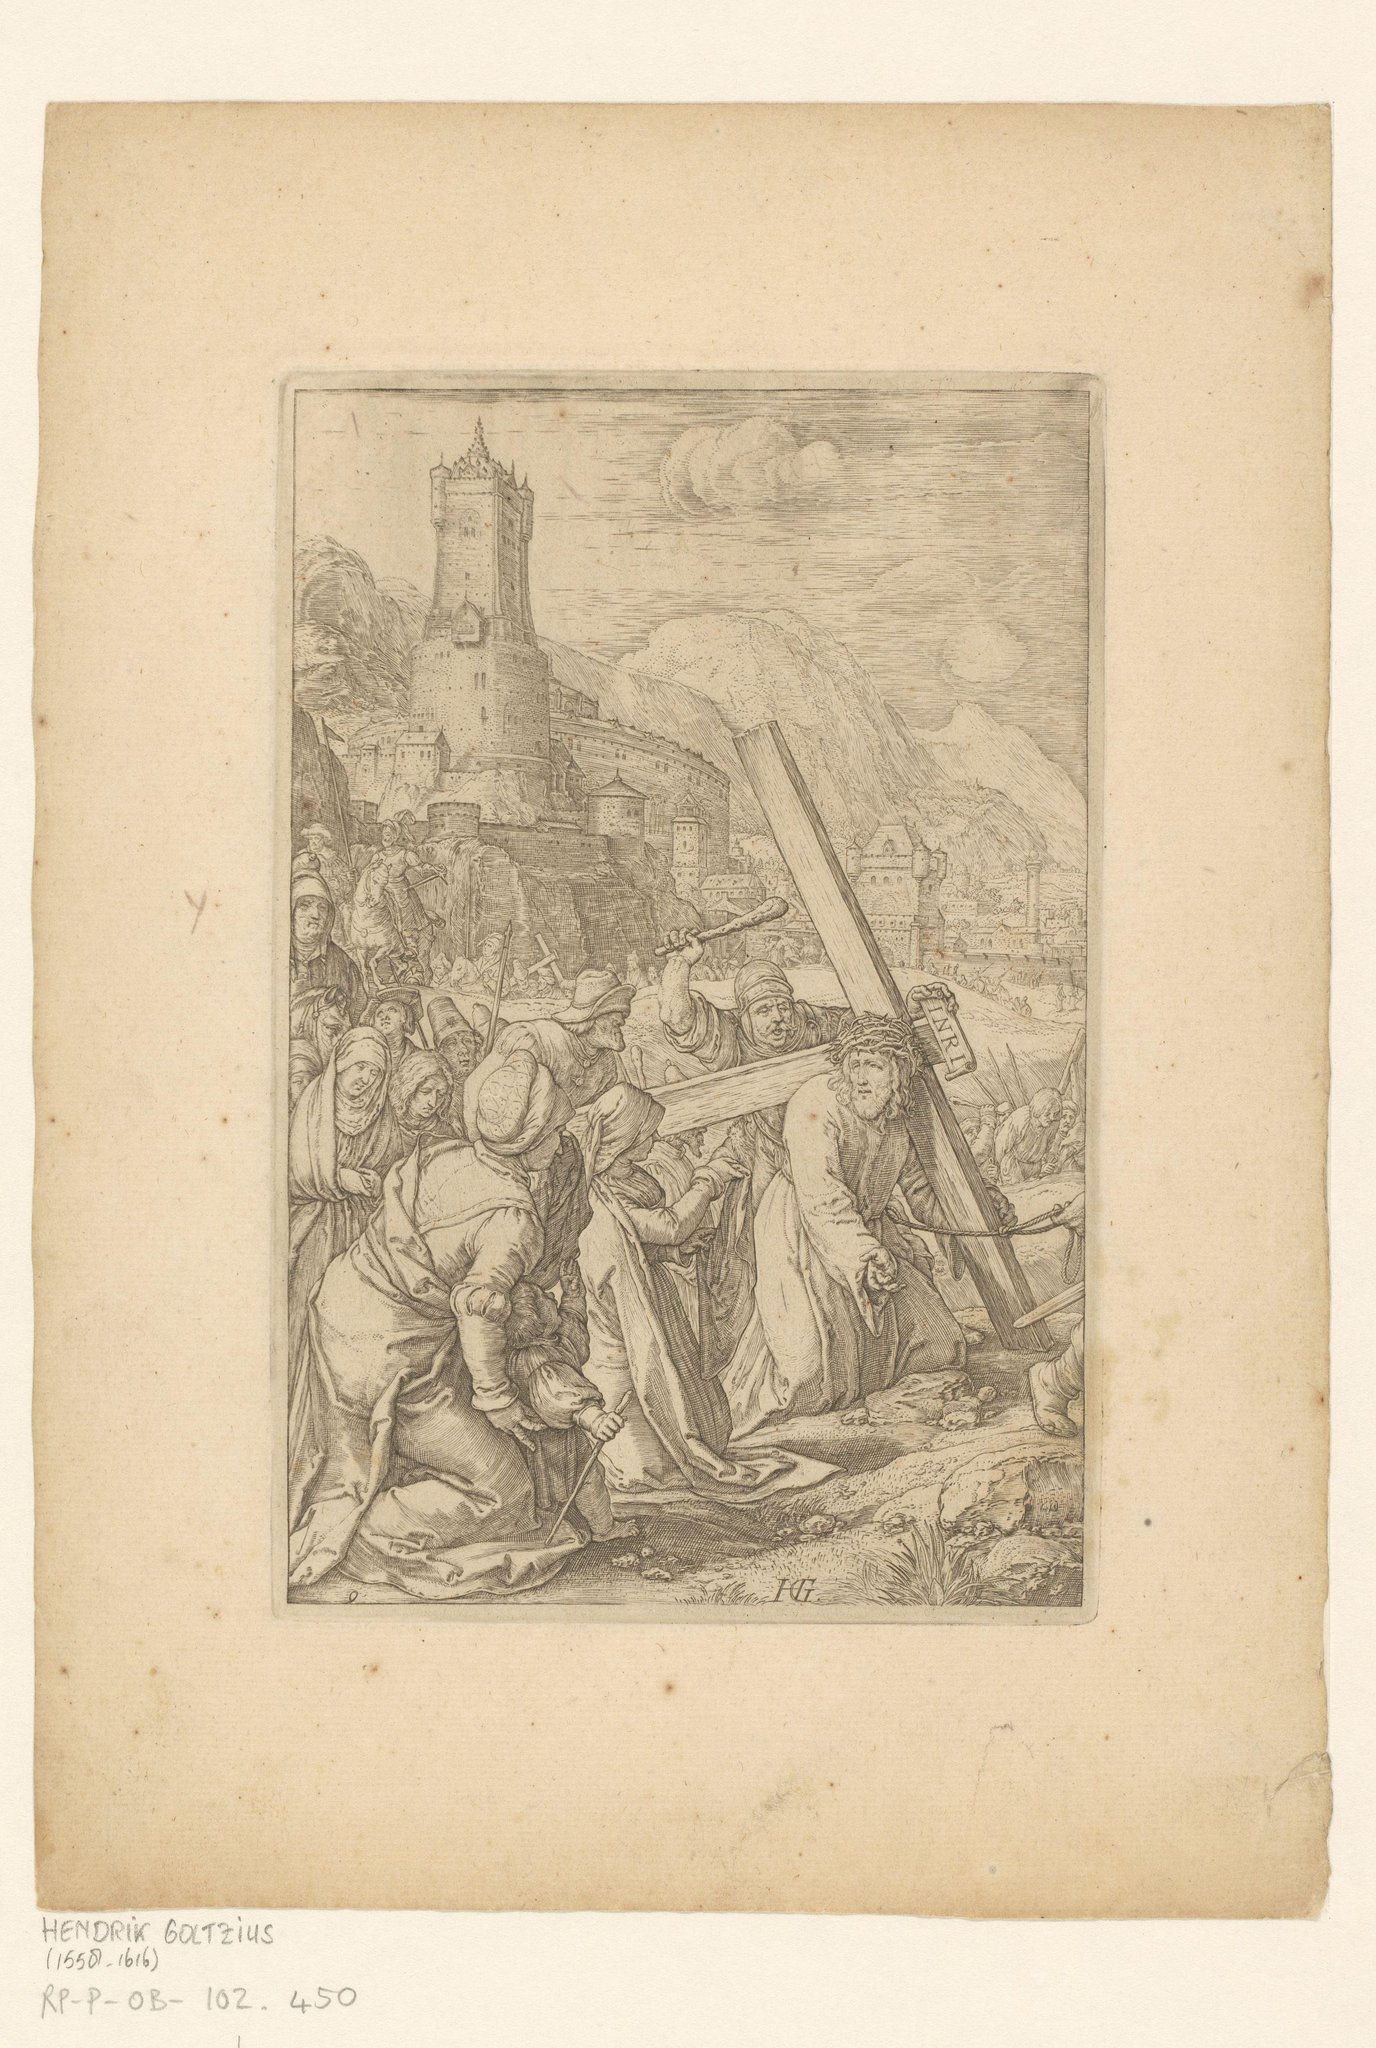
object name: print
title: Kruisdraging met de Heilige Veronica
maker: hendrick goltzius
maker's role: draughtsman, painter, print maker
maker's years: 1558-1617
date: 1596-1598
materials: paper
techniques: engraving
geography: haarlem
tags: christ meets veronica, who has a cloth to wipe christ's face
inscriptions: collector's mark: Lugt 2228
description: De twaalf bladen van deze serie zijn gegraveerd in de stijl van Lucas van Leyden, maar ook komen delen van de composities overeen met gedeeltes van Dürers Passie. Er bevindt zich een ongedateerde tekening die gediend heeft als model voor de prent in het Museum für Bildende Kunst in Leipzig (afgebeeld in Reznicek, zie literatuur).